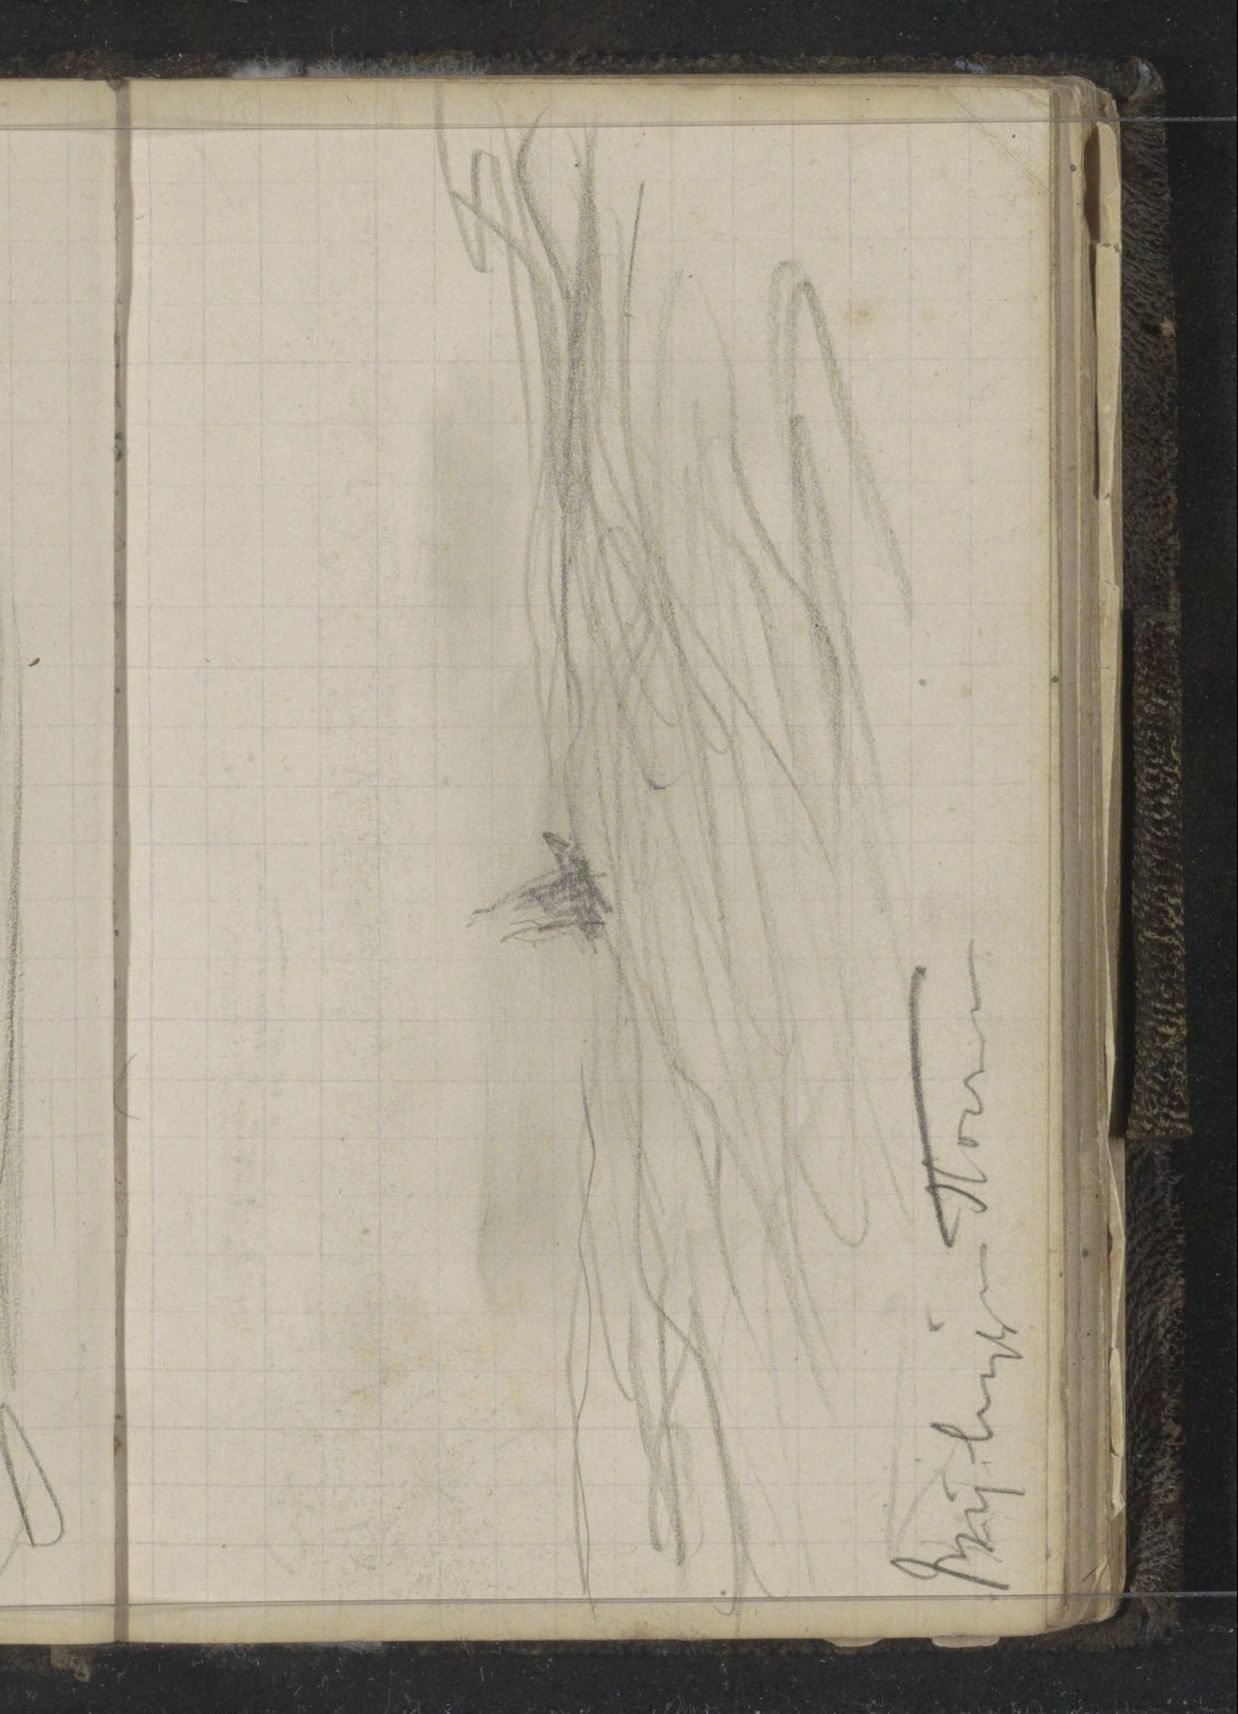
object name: sketchbook leaf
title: Reisverslag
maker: louis apol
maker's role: draughtsman, painter, print maker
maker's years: 1850-1936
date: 1809-1880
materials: pencil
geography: barentsz sea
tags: nova zembla expedities 1880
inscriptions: annotation: ‘[...]’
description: Blad 70 recto uit een schetsboek met 110 bladen betekend tijdens de expeditie naar Nova Zembla in 1880.